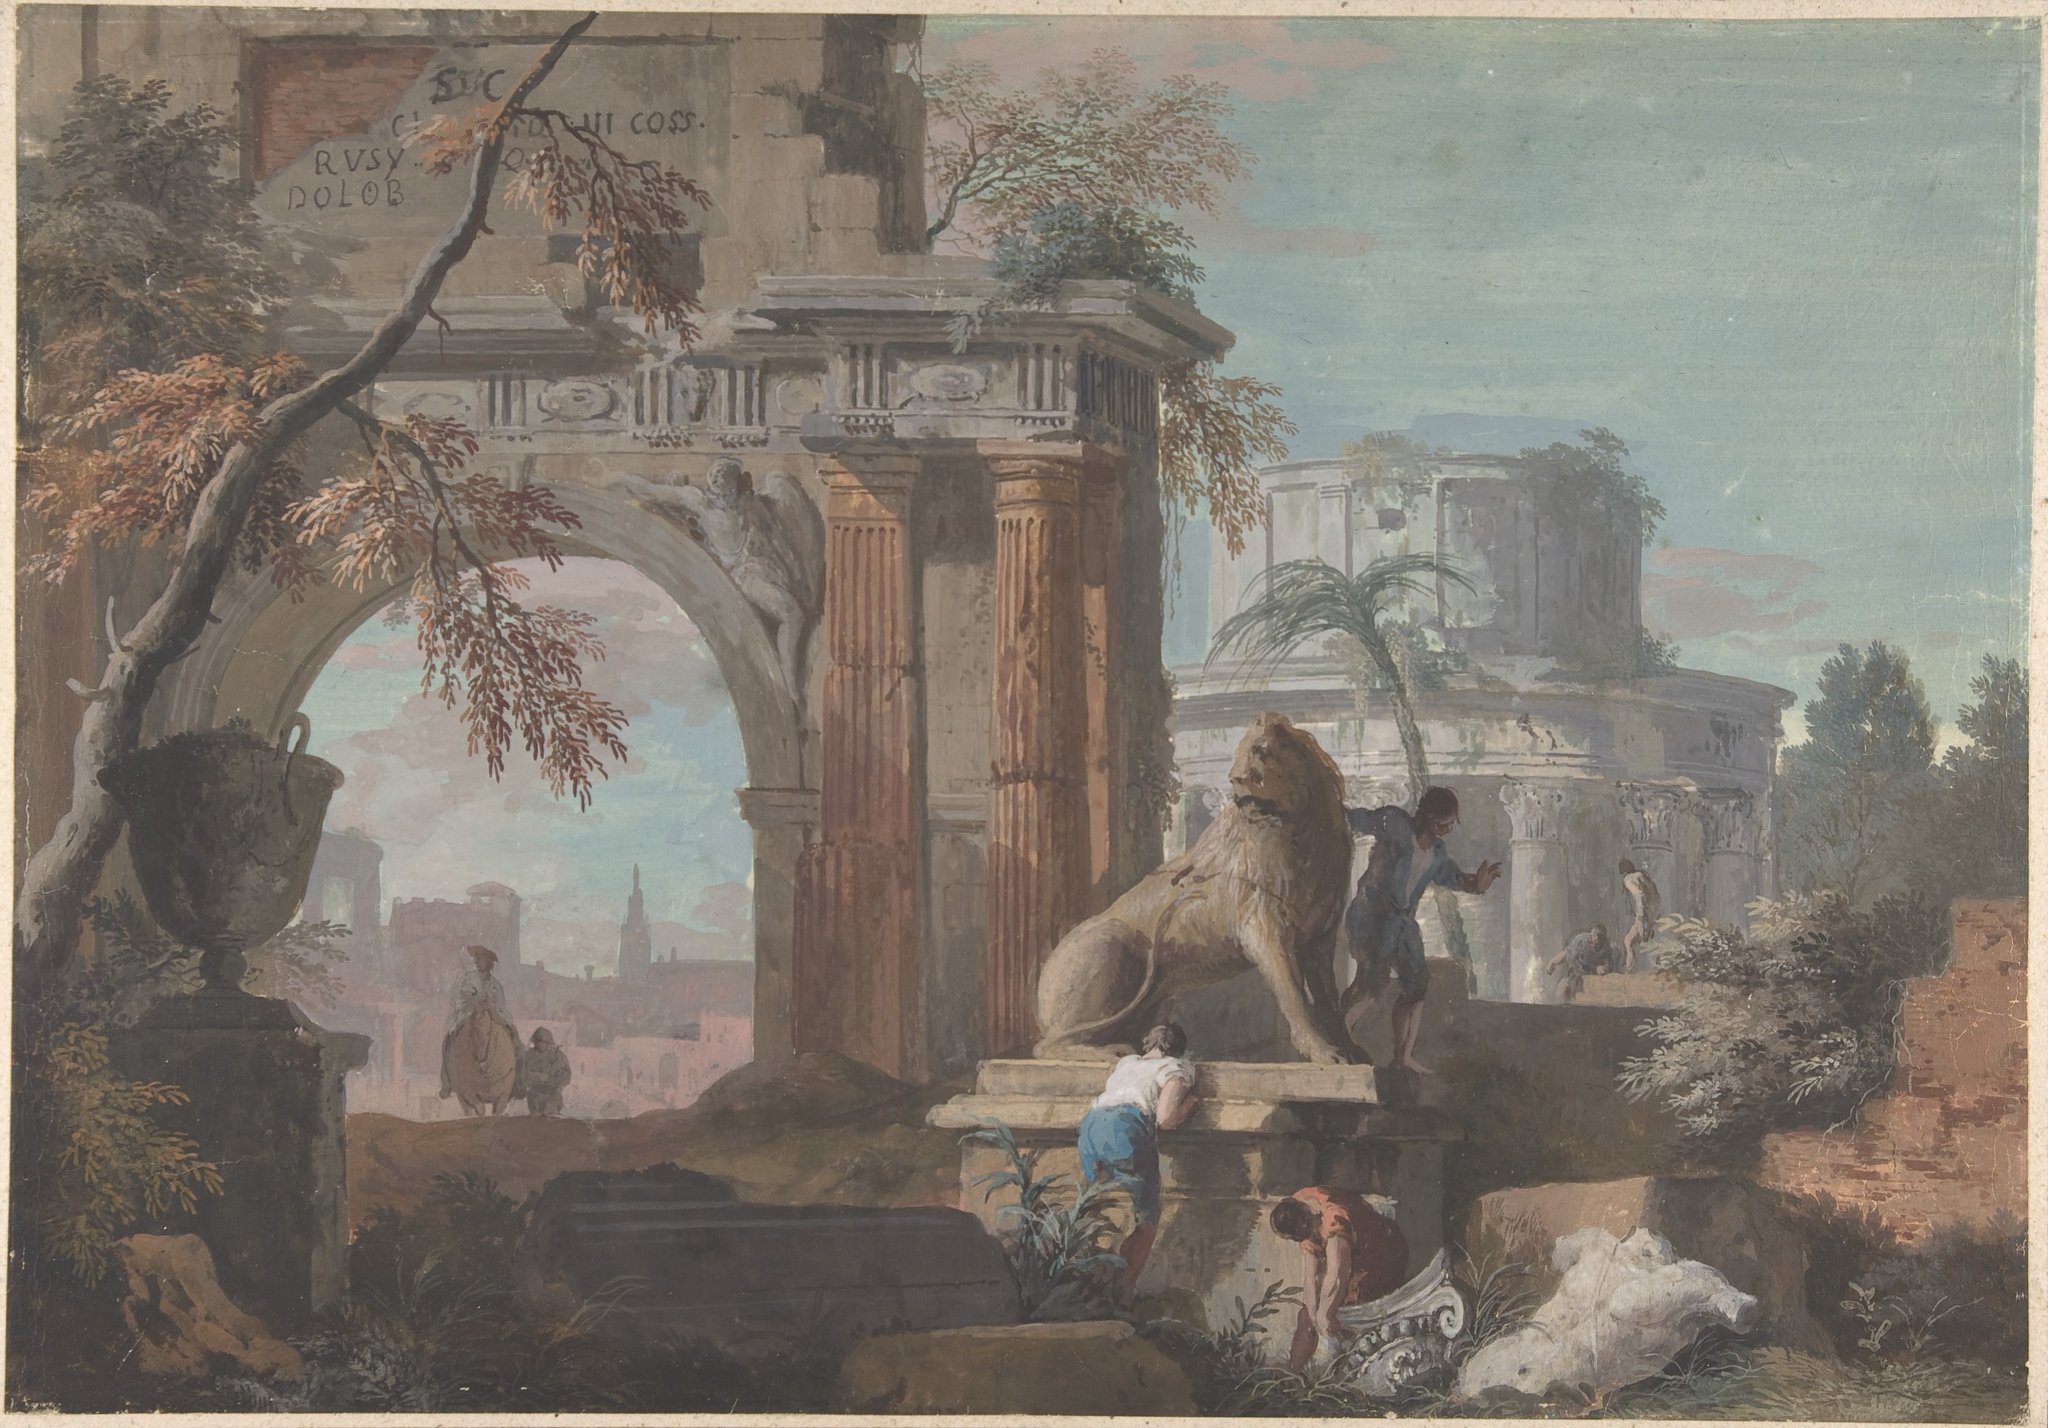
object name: drawing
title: Capriccio with Roman Ruins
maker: marco ricci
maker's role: artist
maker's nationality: italian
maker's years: 1676-1730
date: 1676-1730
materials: gouache, paper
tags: arches,ruins,lions